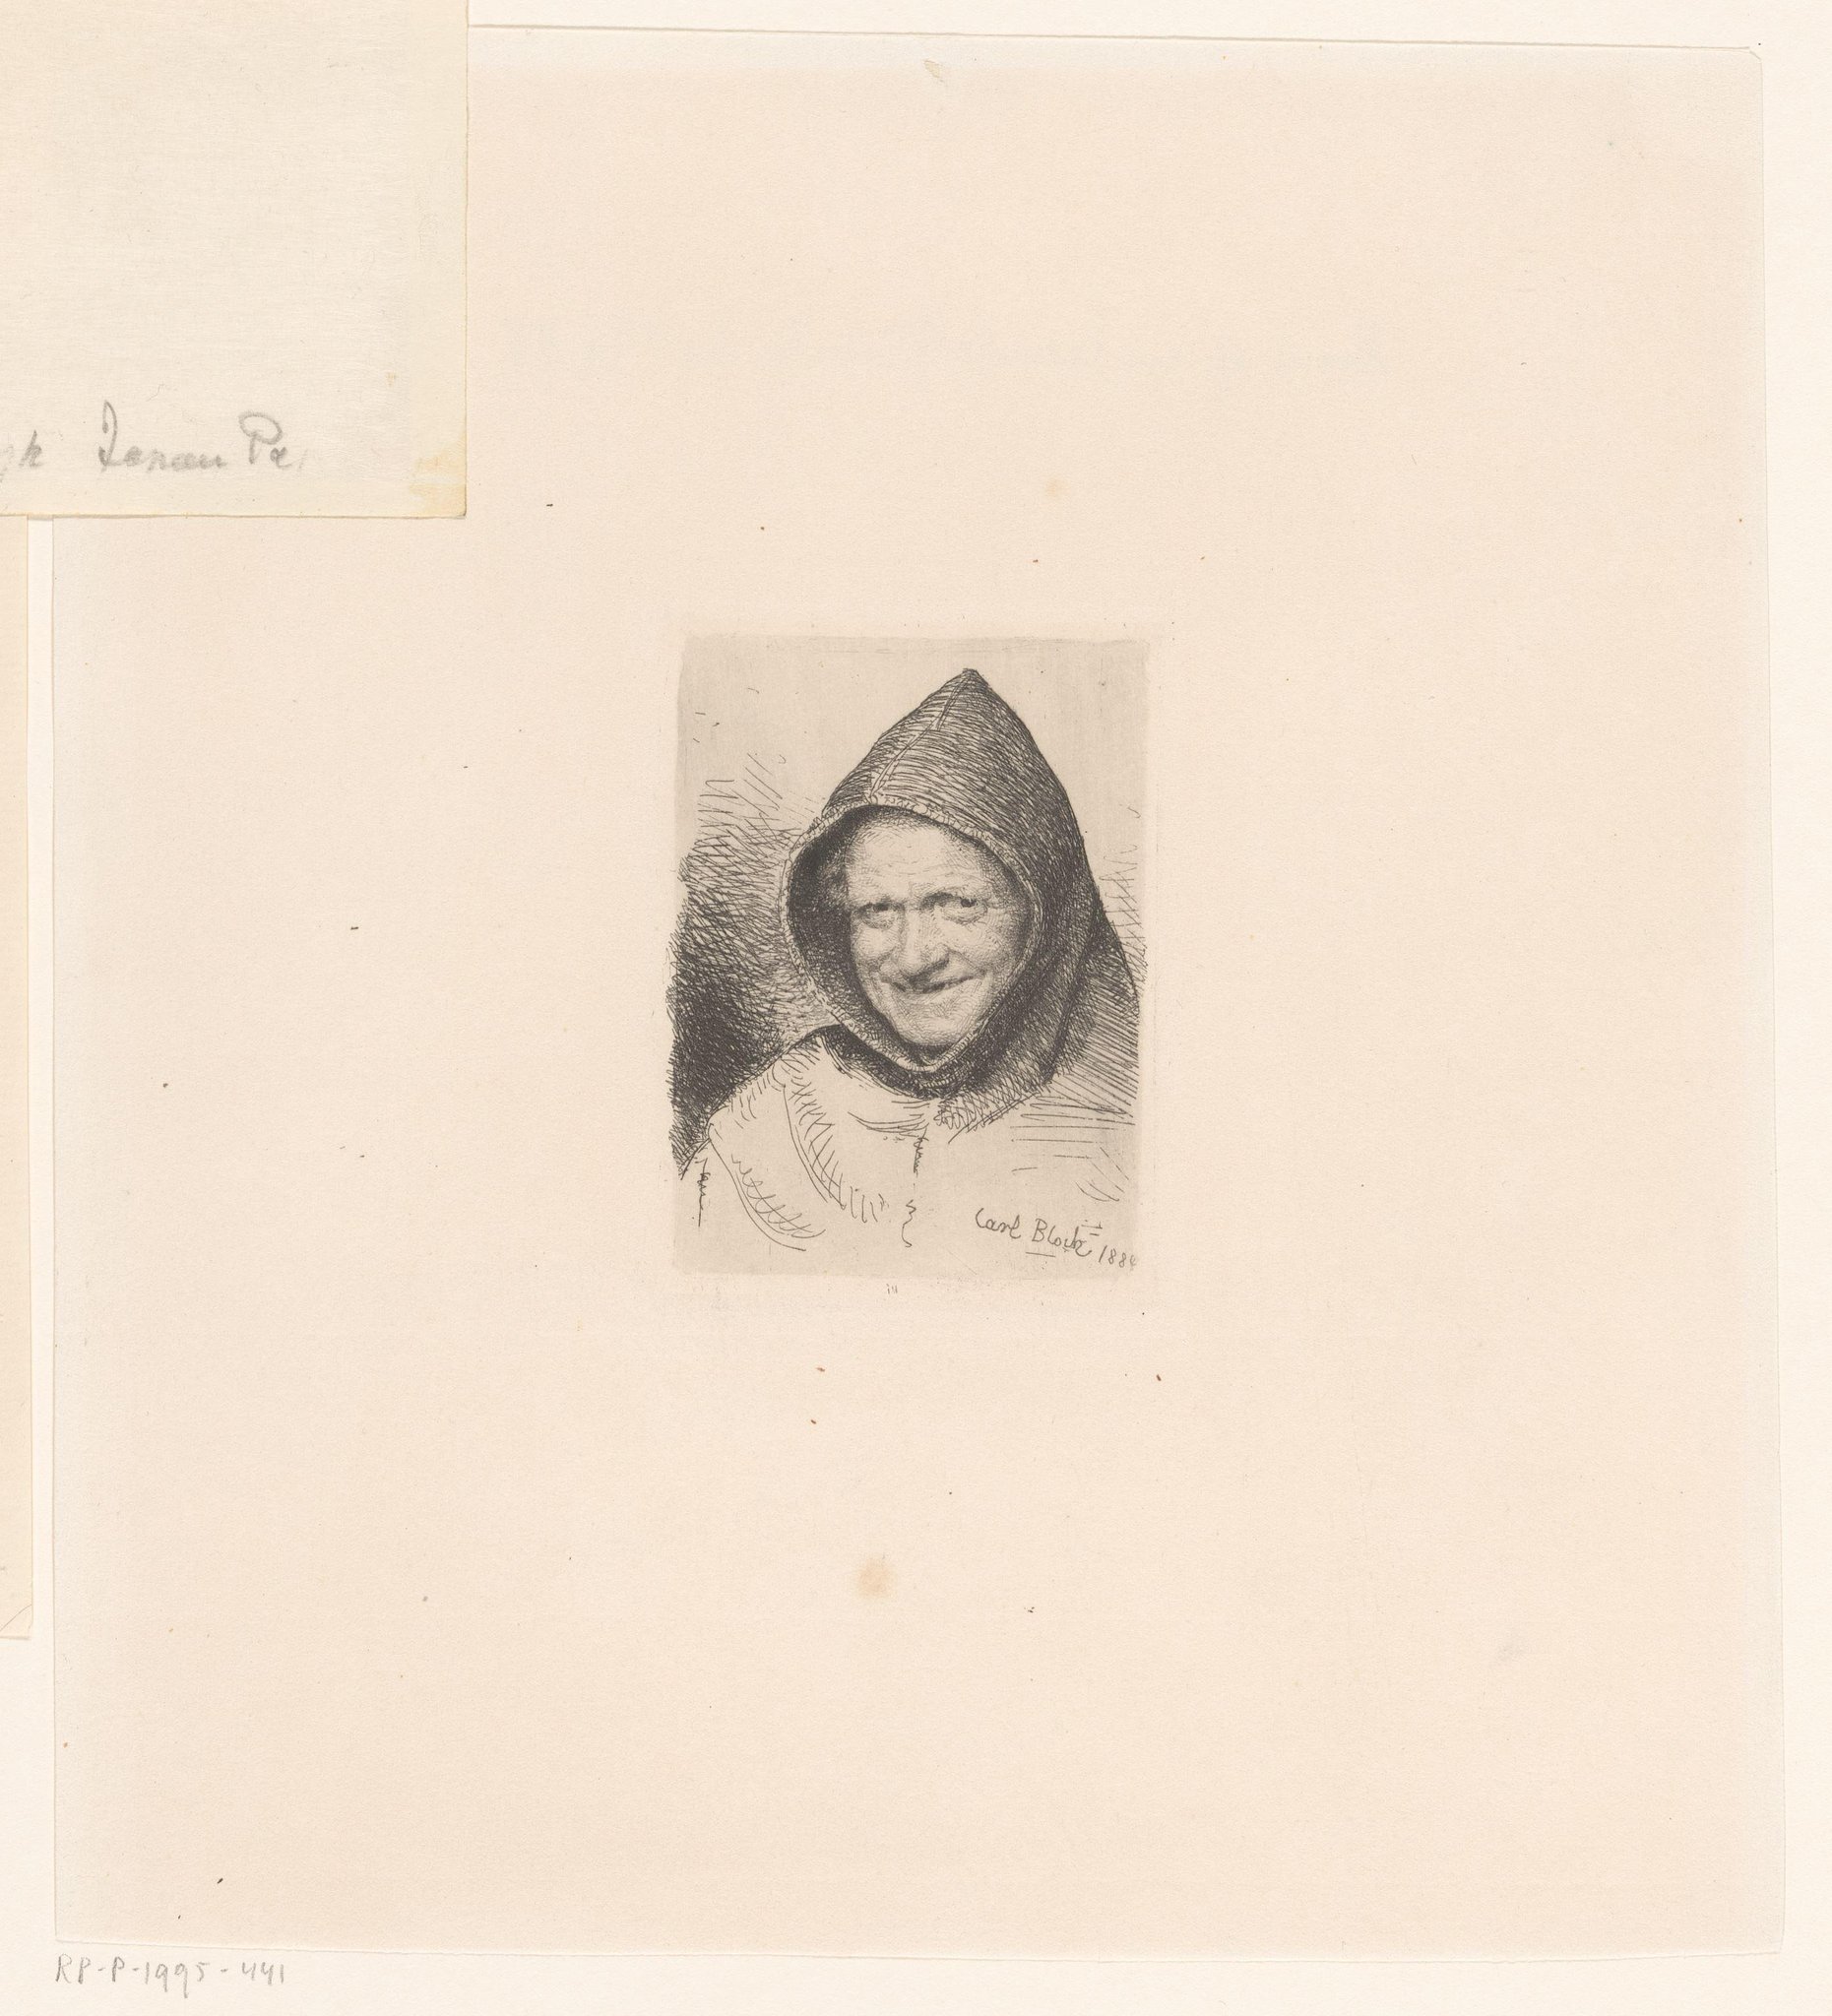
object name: print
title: Kop van een monnik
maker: carl bloch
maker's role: print maker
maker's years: 1834-1890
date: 1888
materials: paper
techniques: drypoint, etching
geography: scandinavia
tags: monk(s), friar(s)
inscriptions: collector's mark: Lugt 2228, signature and date: ‘r.o. gesigneerd en gedateerd Carl Bloch 1888’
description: Kop van een lachende monnik, naar links.